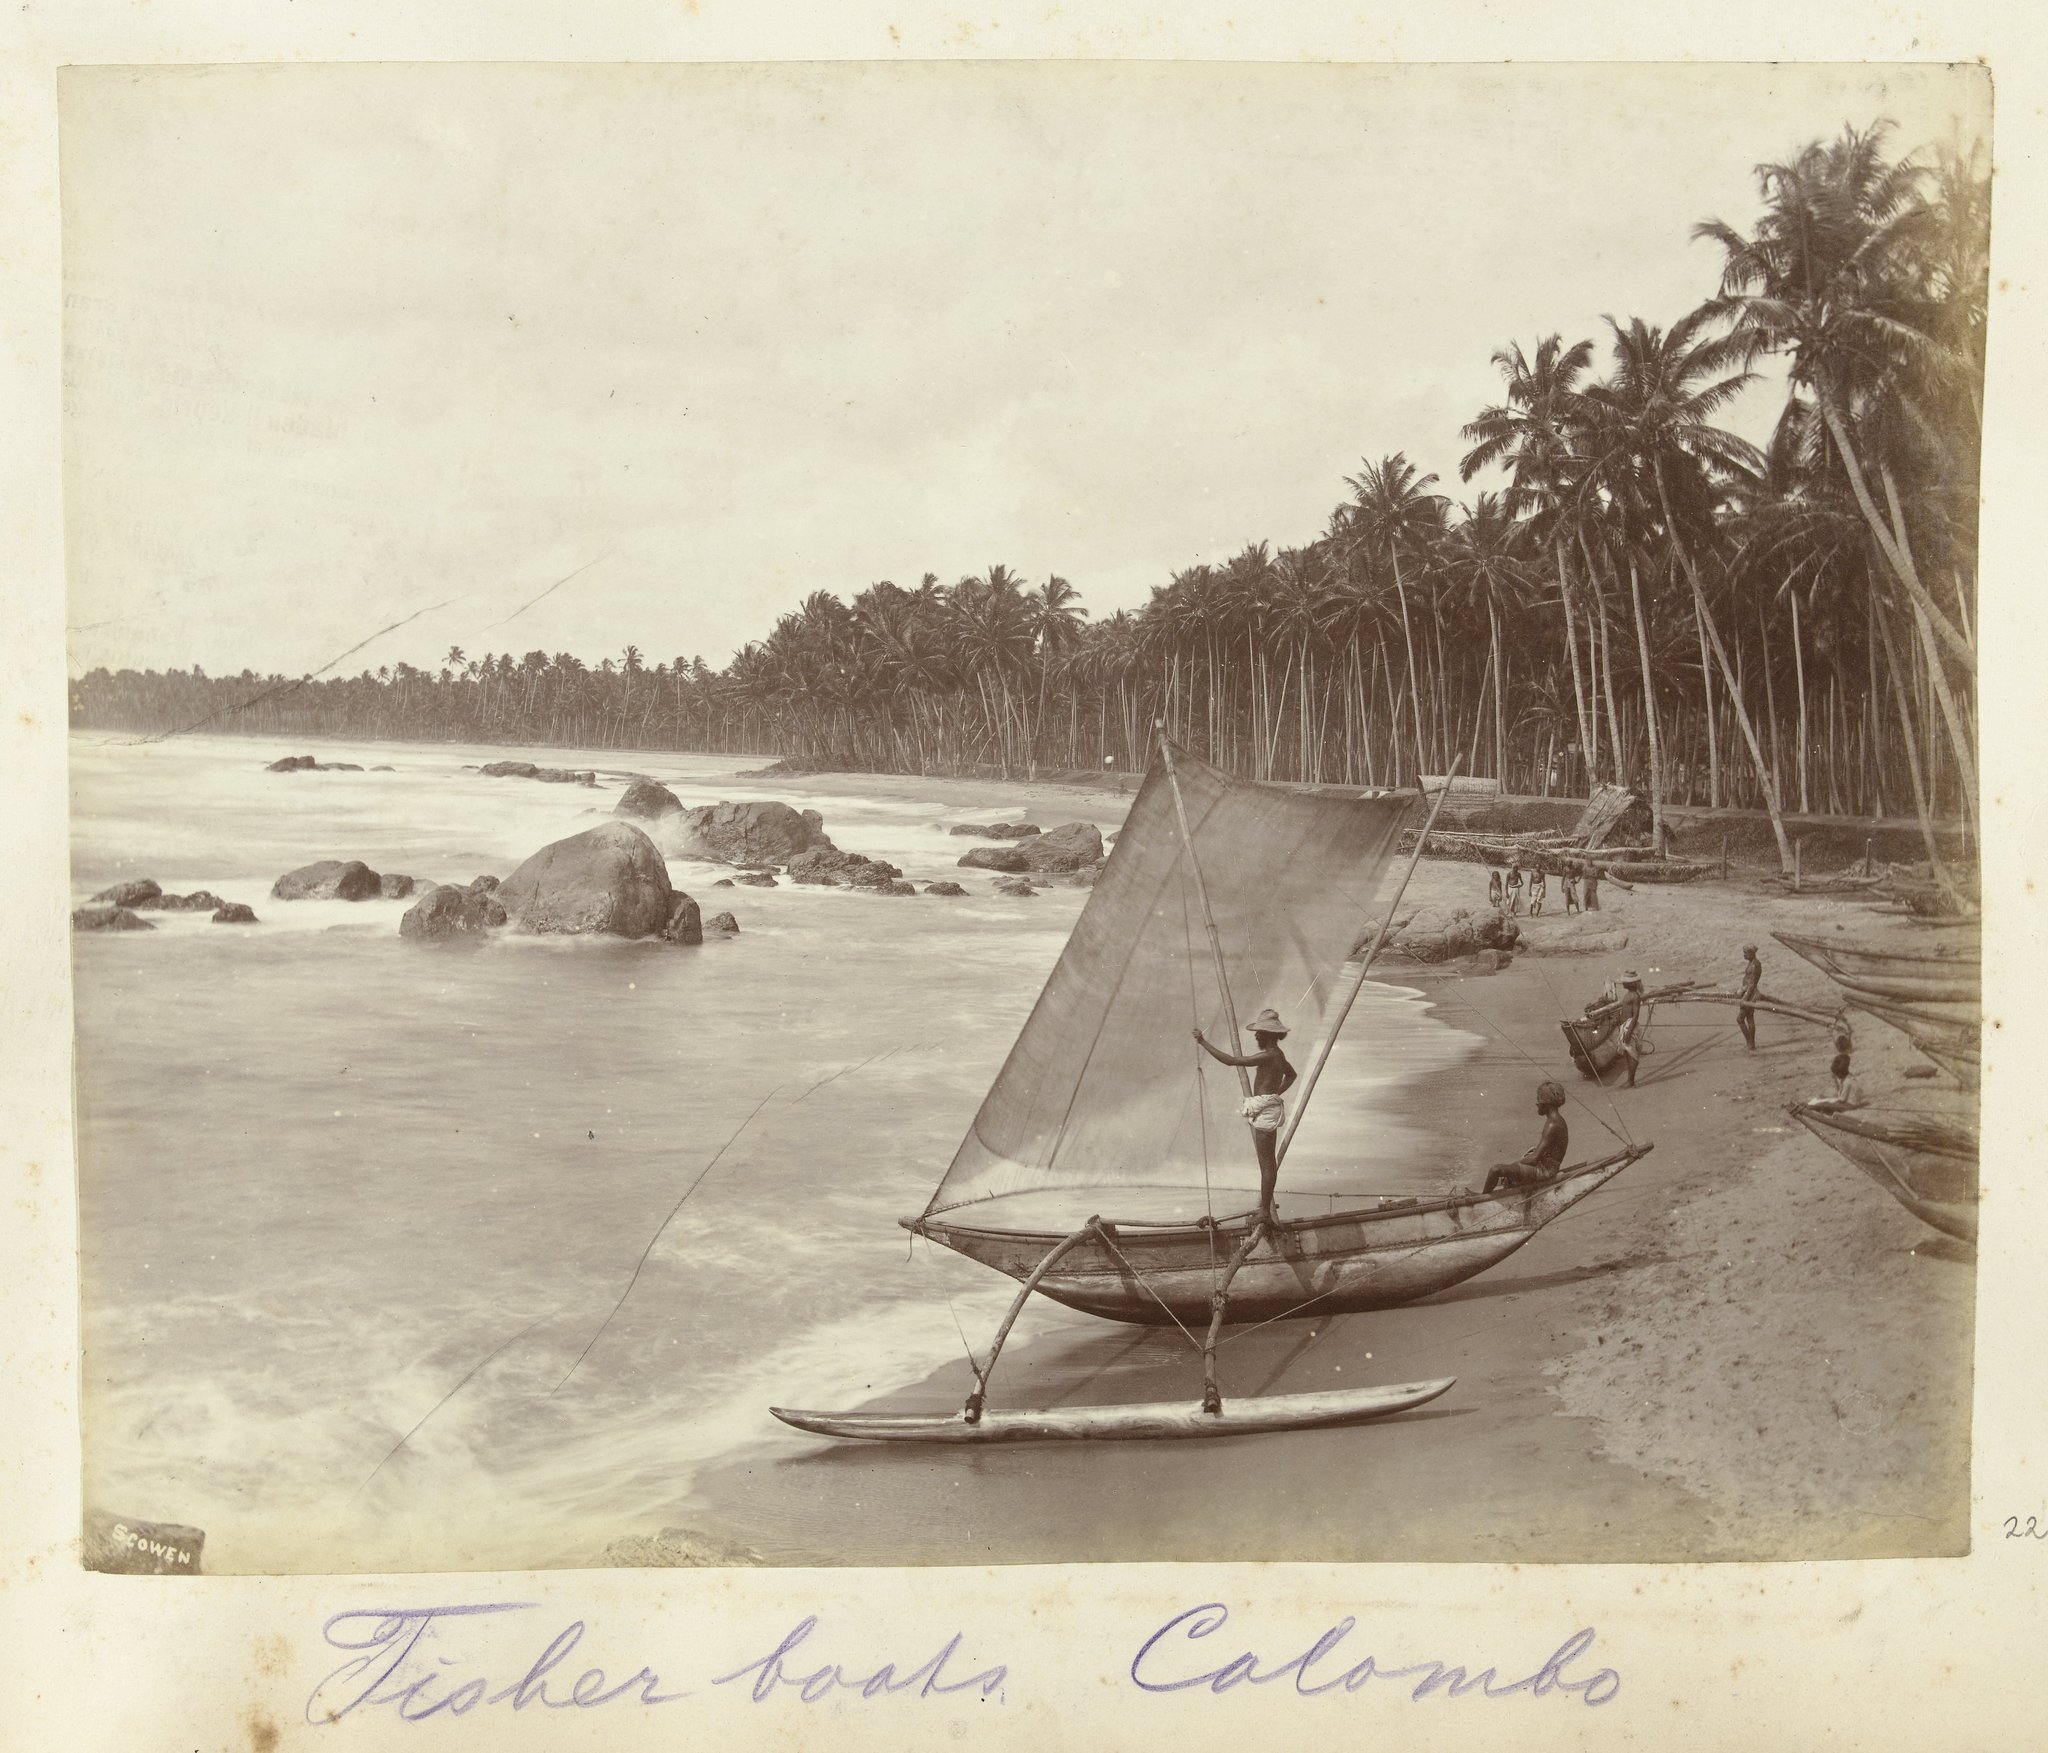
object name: photograph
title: Fisher boats Colombo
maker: Anonymous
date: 1890-1910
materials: cardboard, paper, photographic support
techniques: gelatin silver print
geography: netherlands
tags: colombo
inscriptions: caption: ‘Fisher boats Colombo’